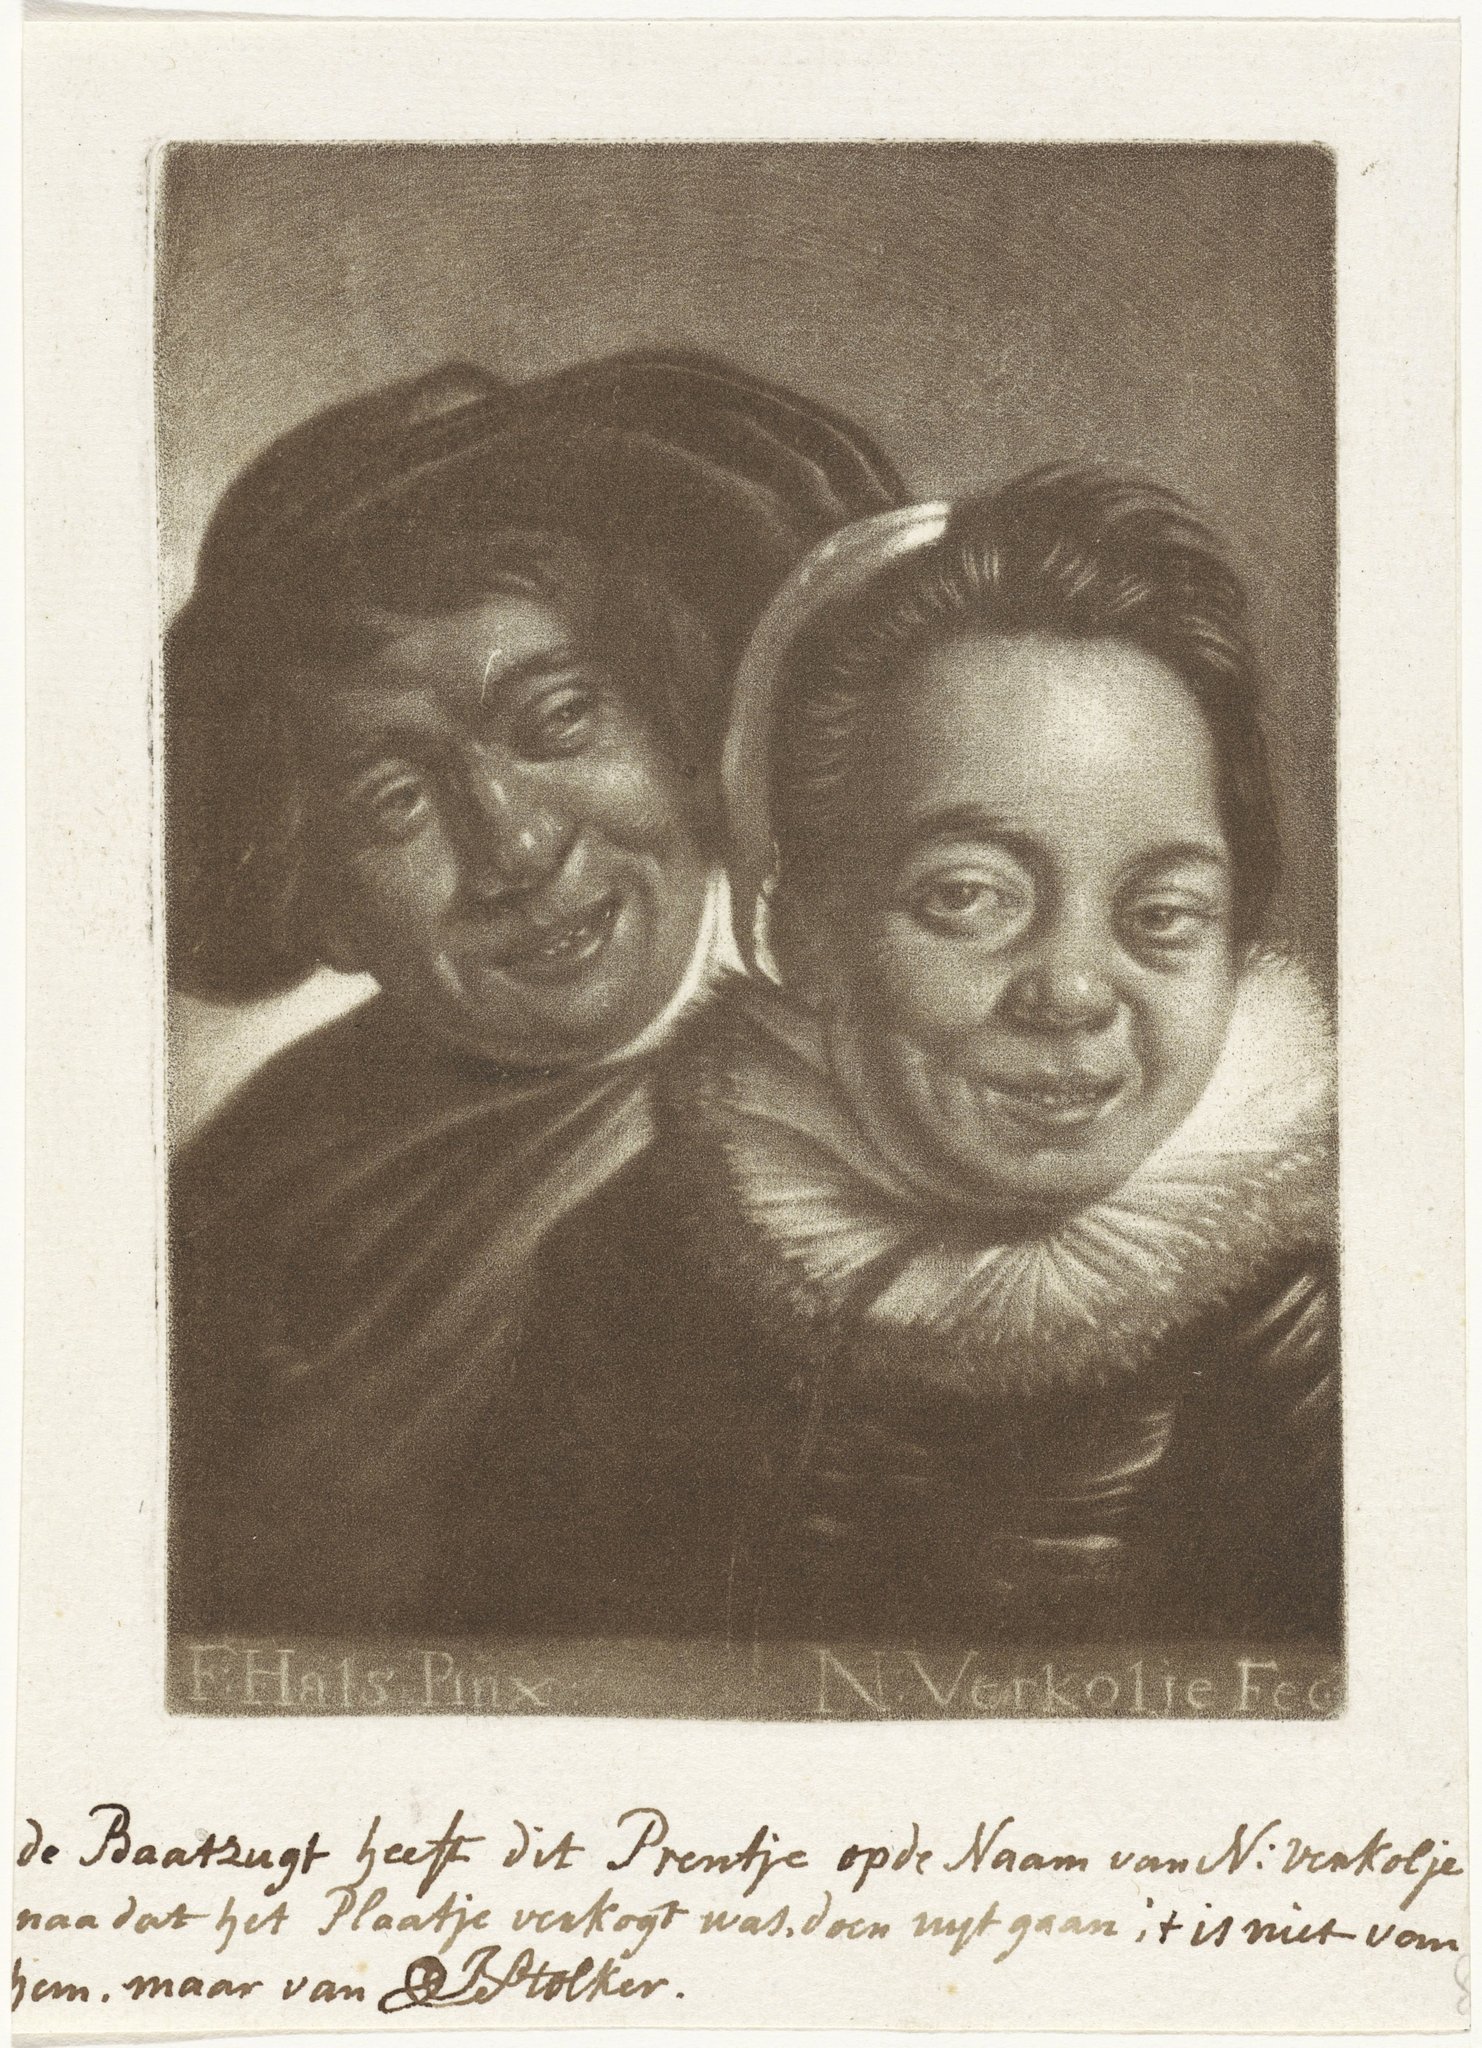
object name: print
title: Lachend paar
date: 1734-1785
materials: paper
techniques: mezzotint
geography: northern netherlands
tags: laughing, head-gear: hat (+ men's clothes)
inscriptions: collector's mark: Lugt 240, inscription: ‘de Baatzugt heeft dit Prentje opde Naam van N: Verkolje / naadat het Plaatje verkogt was, doen uytgaan, 't is niet van / hem, maar van J Stolker’